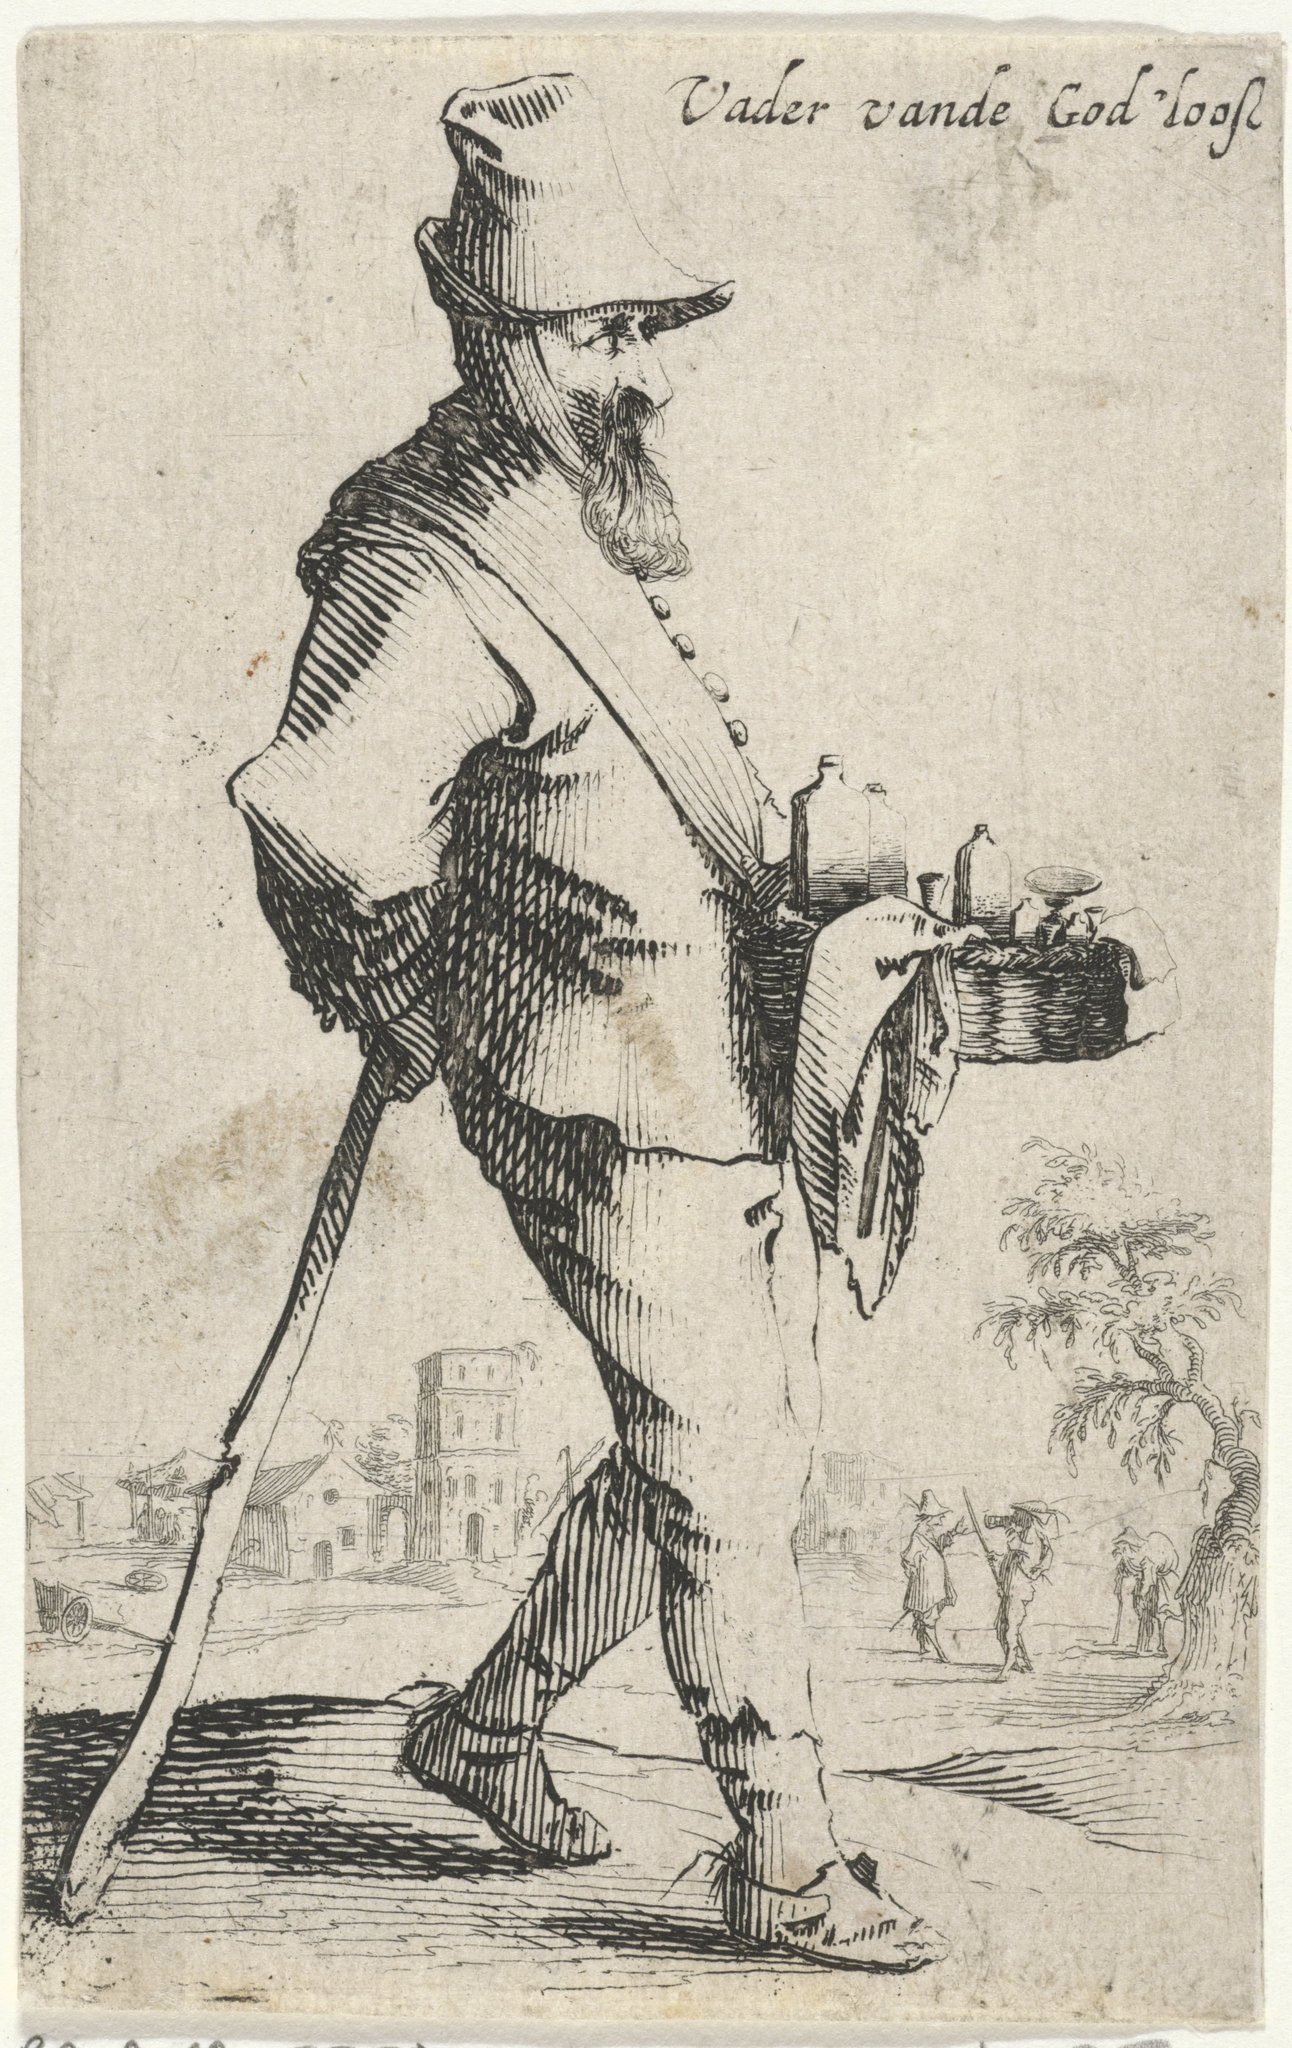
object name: print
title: T'Leven Der Boeren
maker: salomon savery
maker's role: print maker, publisher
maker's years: 1594-1683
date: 1630-1665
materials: paper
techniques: engraving, etching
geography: amsterdam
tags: walking-stick, staff, wandering or travelling merchant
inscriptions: collector's mark: Lugt 240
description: De prent maakt deel uit van een twaalfdelige serie prenten met voorstellingen van boeren.